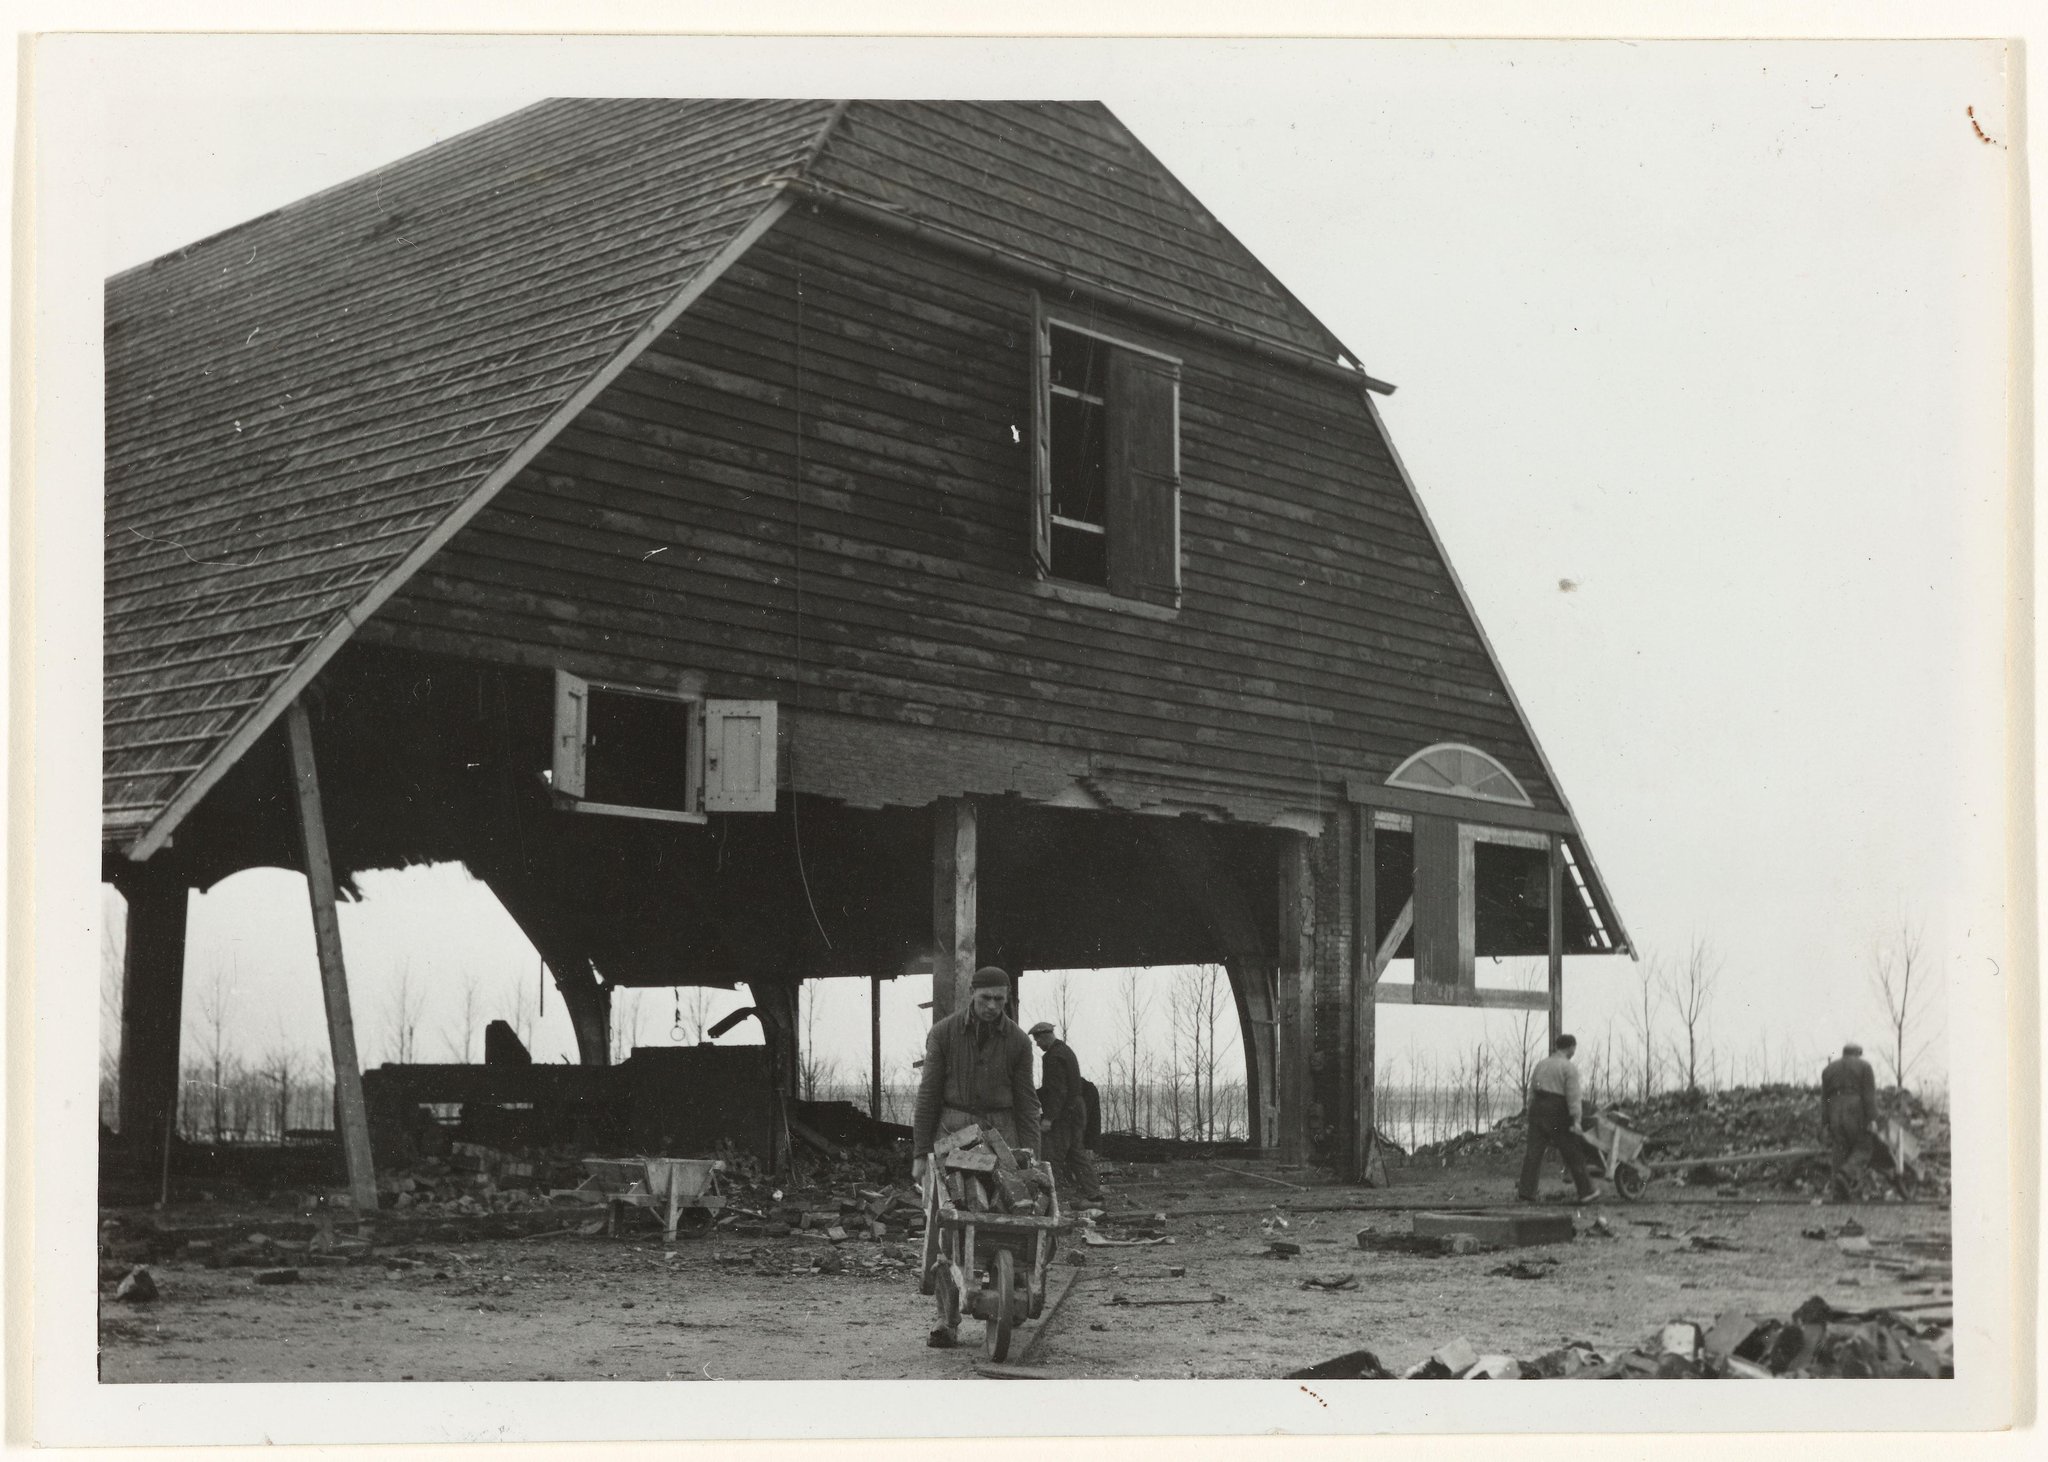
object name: photograph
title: Boerderij in de Wieringermeer na onderwaterzetting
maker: charles breijer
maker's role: fotograaf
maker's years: 1914-2011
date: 1945-1946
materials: photographic support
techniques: photography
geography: slootdorp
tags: farm or solitary house in landscape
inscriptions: inscription, stamp: ‘COPYRIGHT / 'ANEFO' / ALGEMEEN NEDERLANDSCH FOTOBUREAU’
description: Een verwoeste boerderij te Slootdrop in de Wieringermeer nadat deze was drooggemalen nadat ze door de Duitsers onder water was gezet.